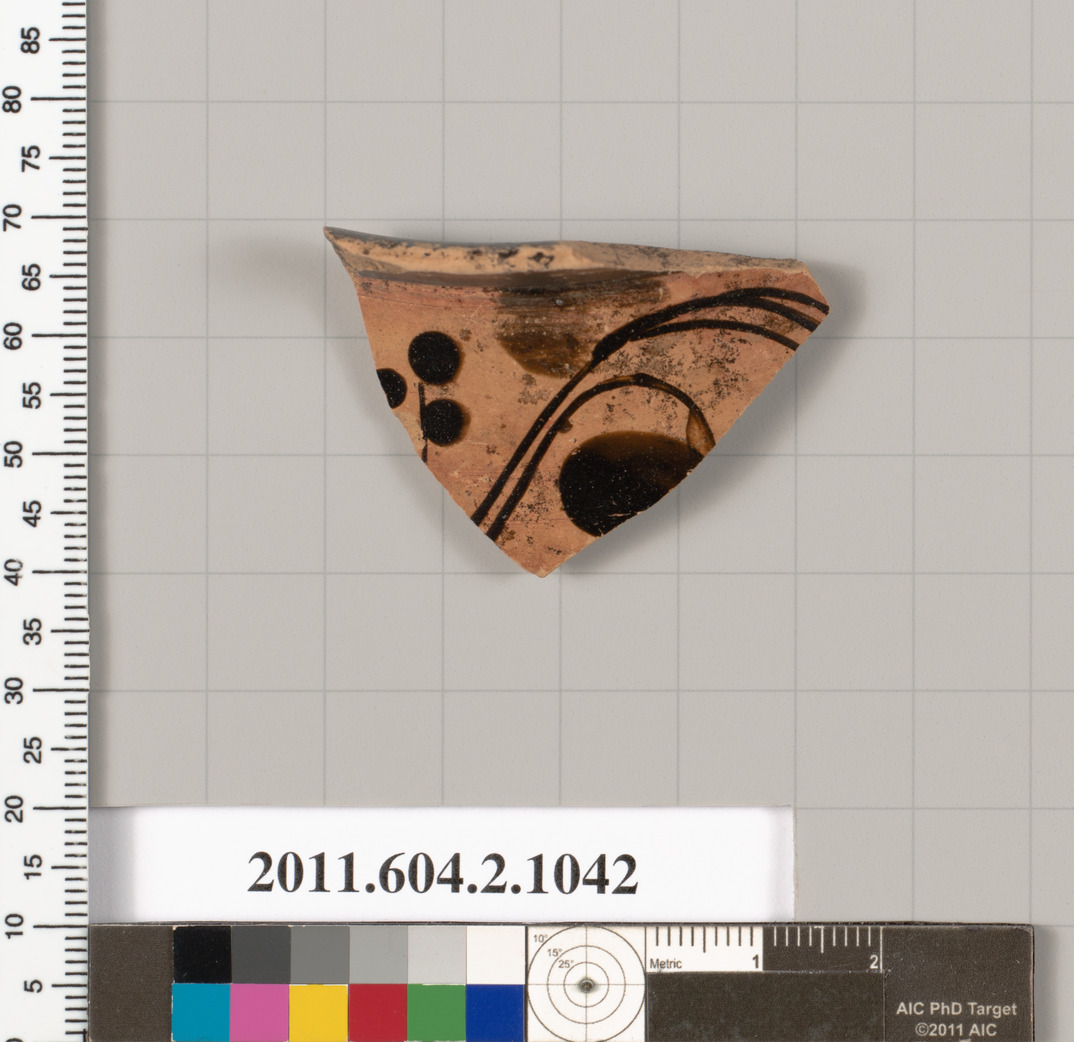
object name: oinochoe fragment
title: Terracotta fragment of an oinochoe (jug)?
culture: greek, attic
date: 534-468 BCE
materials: terracotta